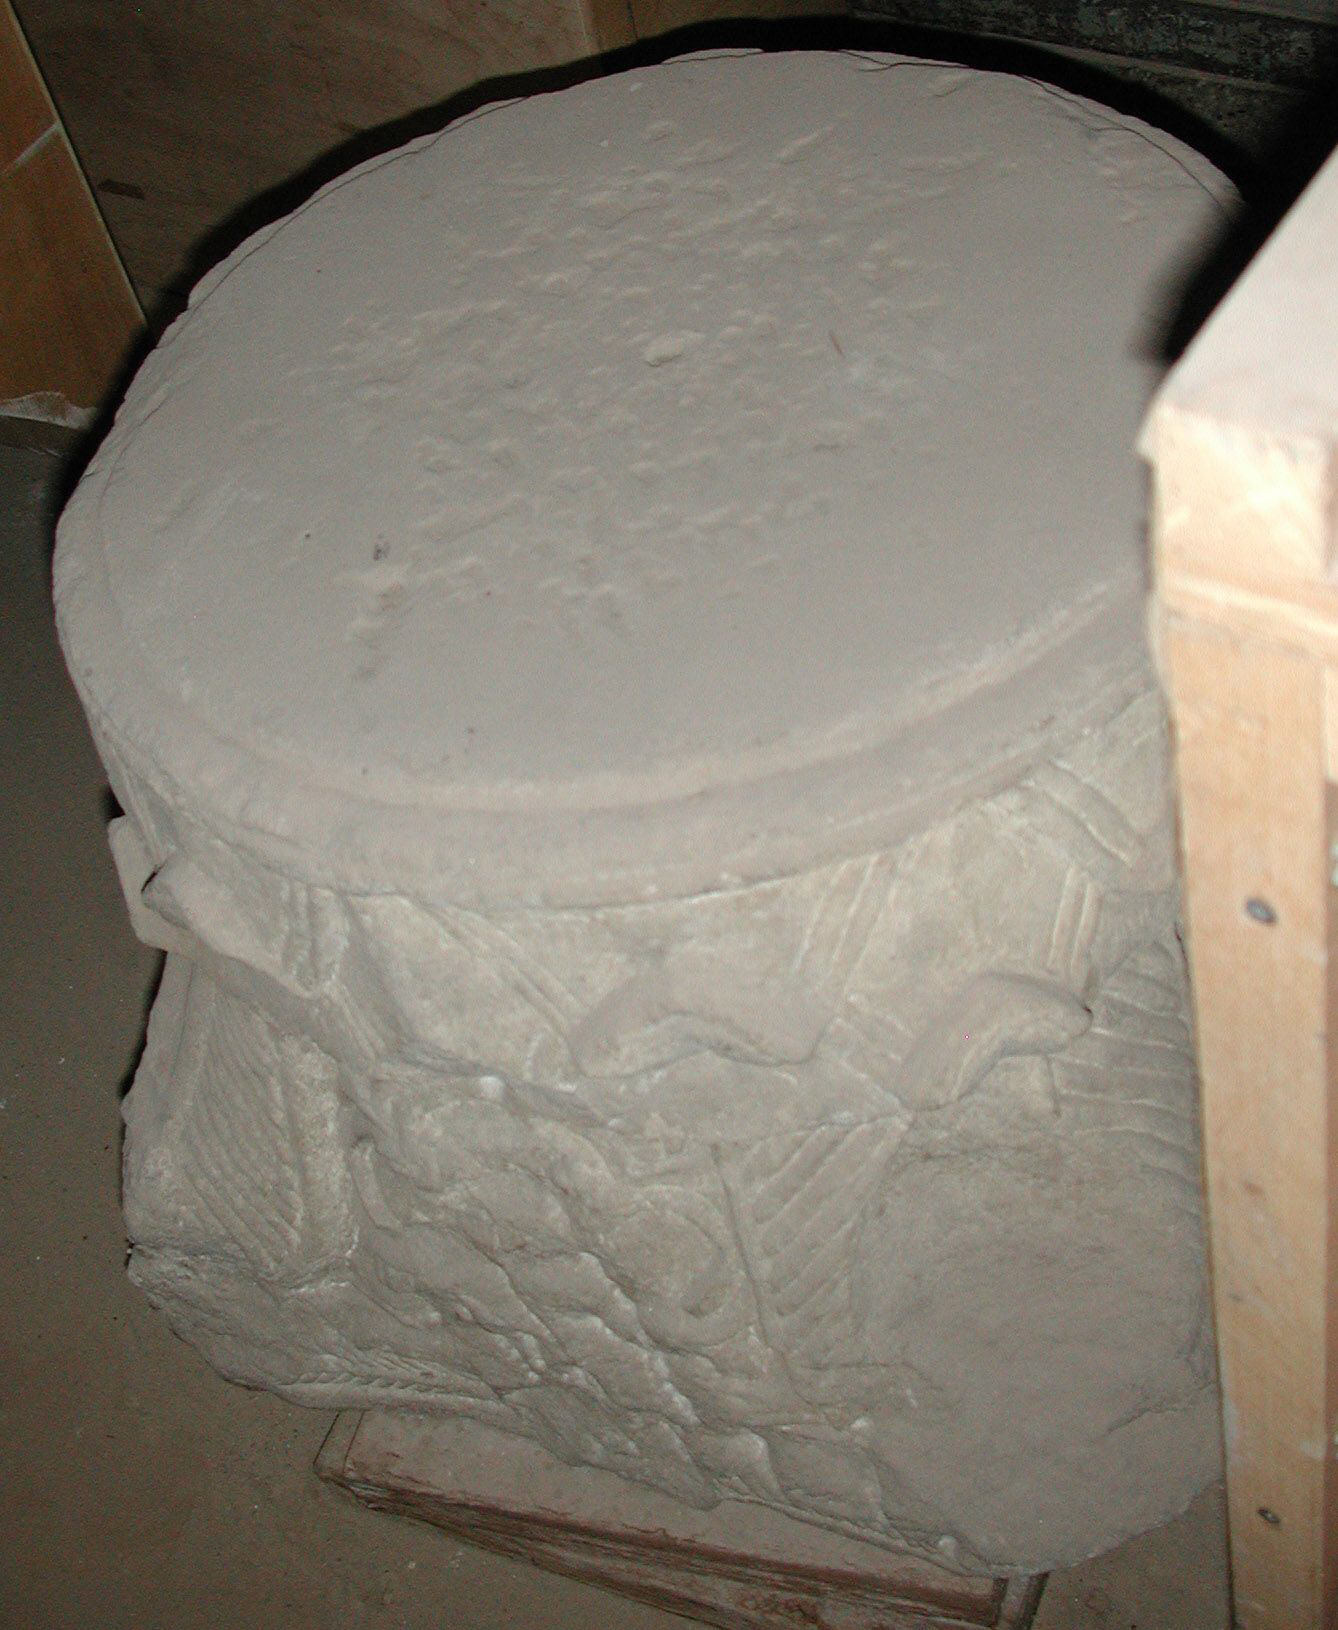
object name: capital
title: Capital with Leaves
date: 401-500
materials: stone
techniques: carving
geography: egypt